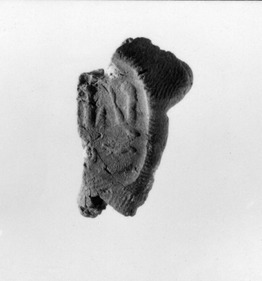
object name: sealing, nebmaatre, amenhotep iii,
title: Document Sealing With the Throne Name of Amenhotep III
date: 1390-1352 BCE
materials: mud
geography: egypt